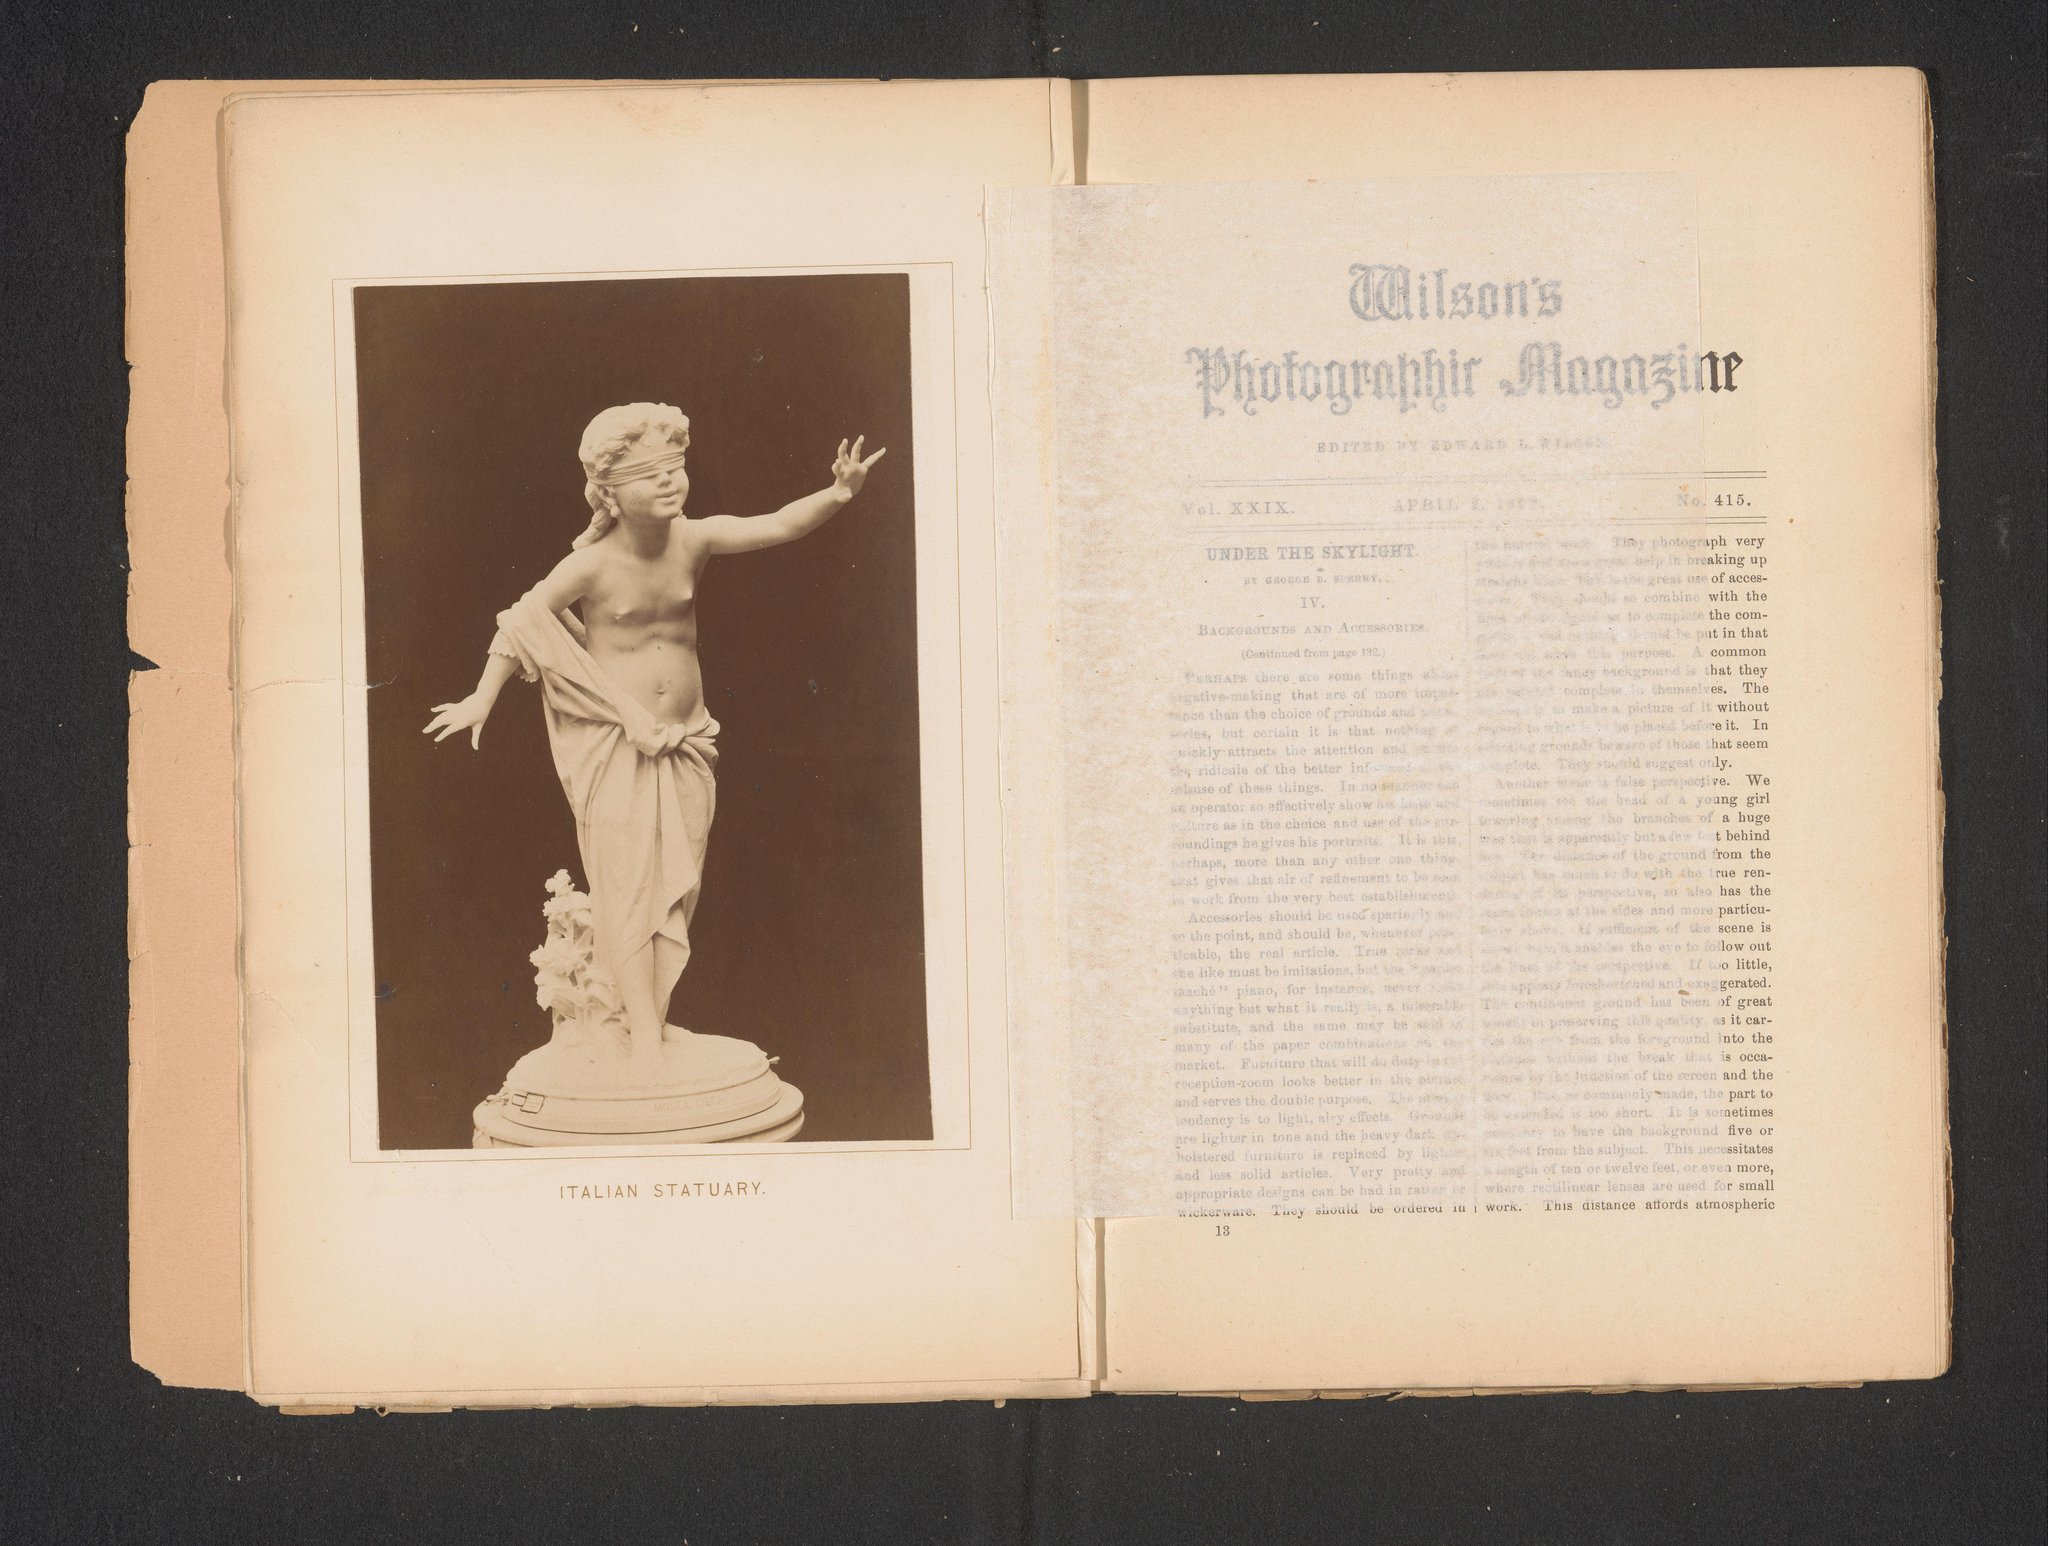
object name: page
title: Italiaans beeldhouwwerk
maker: charles t. fellows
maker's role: printer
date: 1887-1892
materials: photographic support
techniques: albumen print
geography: philadelphia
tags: piece of sculpture, reproduction of a piece of sculpture